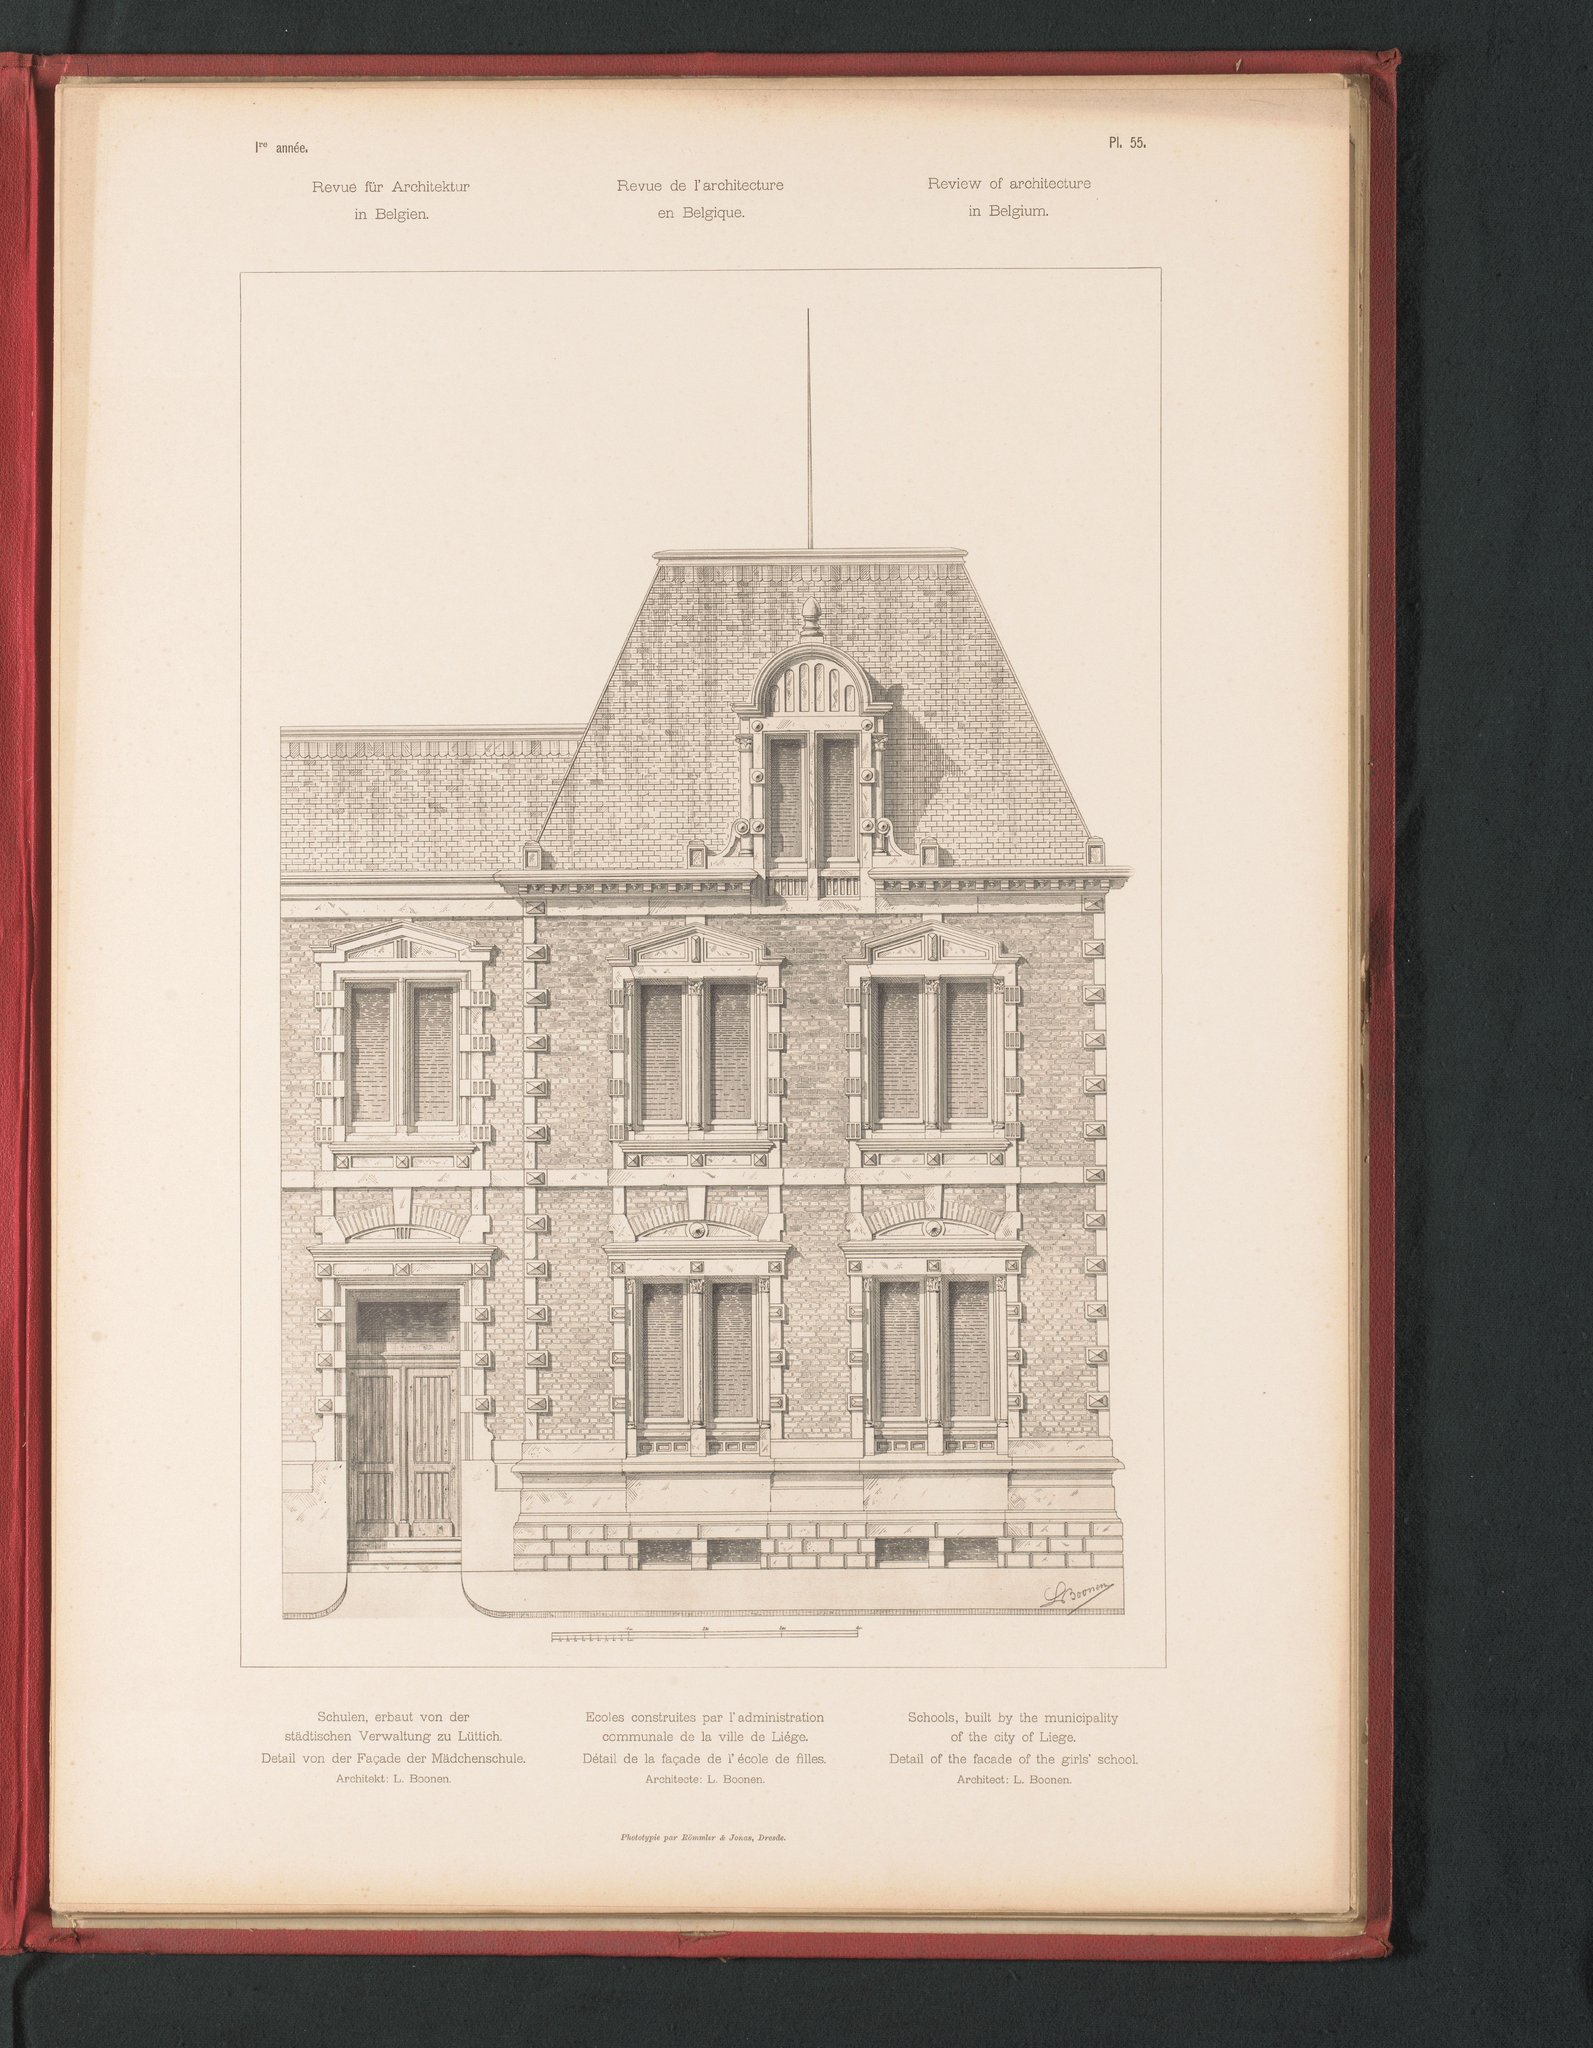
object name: photomechanical print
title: Review of architecture in Belgium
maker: louis boonen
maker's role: architect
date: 1888-1893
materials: paper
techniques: photograph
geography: dresden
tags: housing, exterior ~ architectural design or model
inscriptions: number: ‘Pl. 55.’, inscription: ‘1re. annèe.’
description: Deze prent maakt deel uit van een omslag met 110 prenten op 90 bladen en 18 tekstbladen.